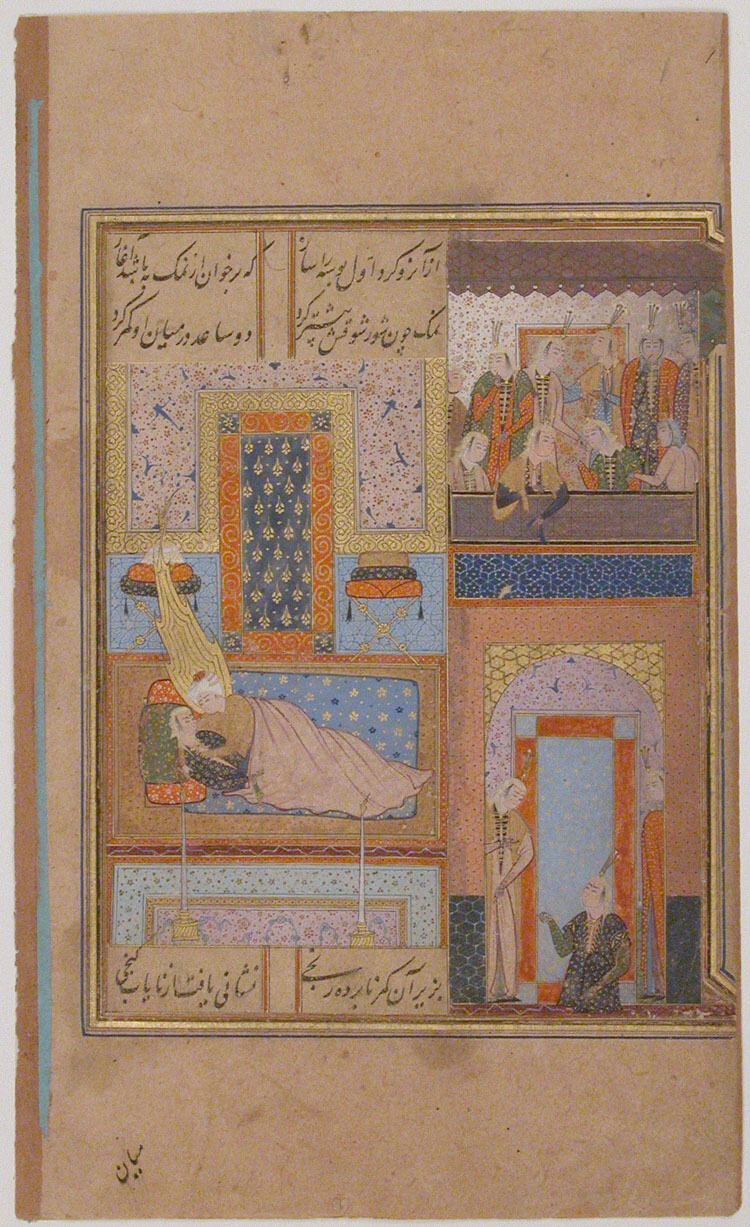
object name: folio from an illustrated manuscript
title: "Yusuf and Zulaykha United After Potiphar's Death", Folio from a Yusuf and Zulaykha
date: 1501-1600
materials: gold, ink, paper, watercolor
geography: iran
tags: men,death